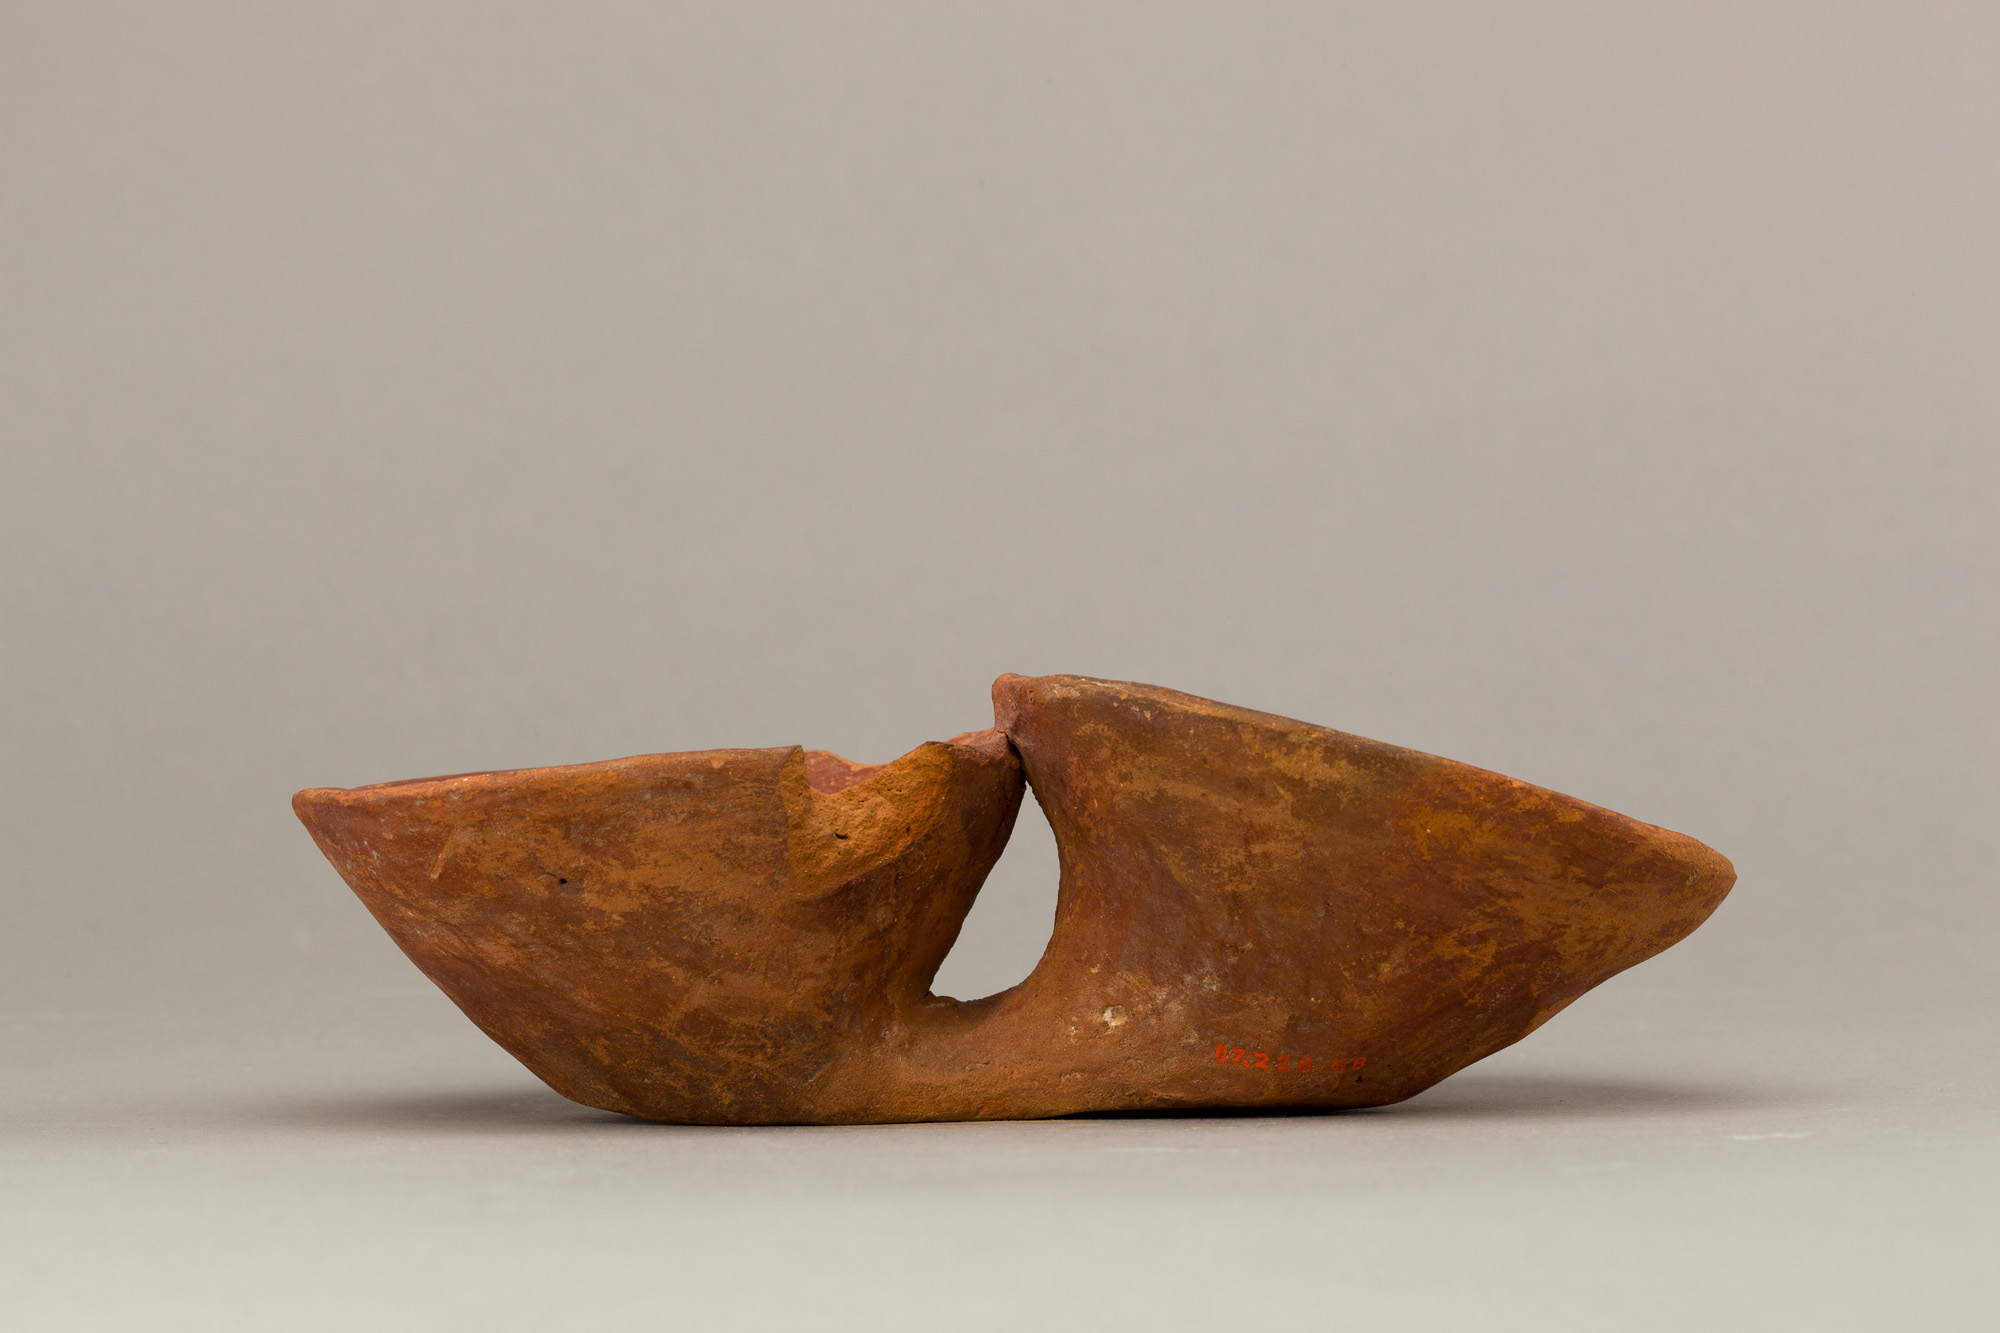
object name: bowl, double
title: Double Bowl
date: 4500-4000 BCE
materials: pottery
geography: egypt